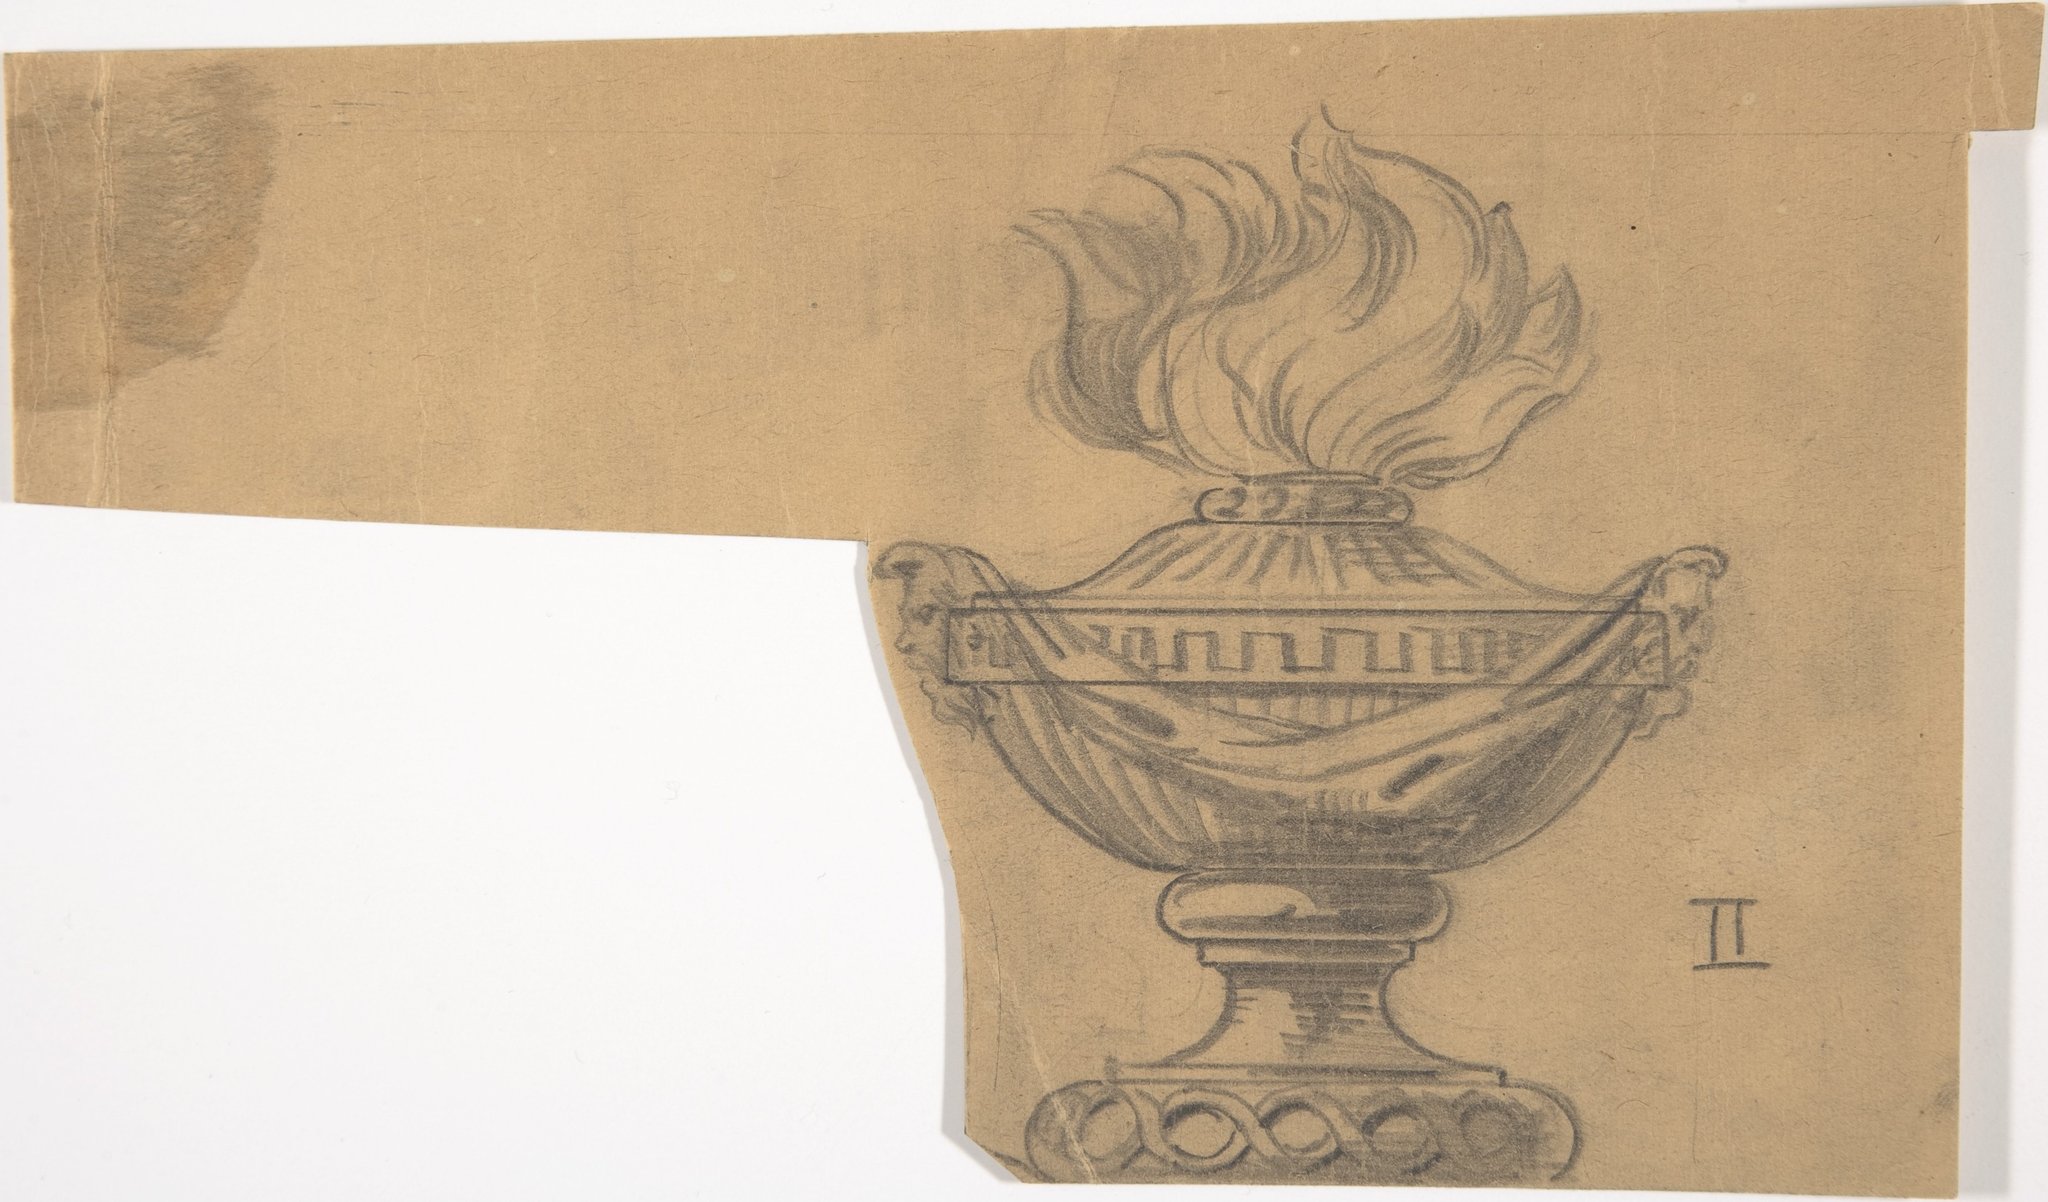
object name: drawing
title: Suggestions for Urns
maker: l. v. grave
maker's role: artist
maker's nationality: british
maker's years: 18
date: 1701-1800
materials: graphite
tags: urns